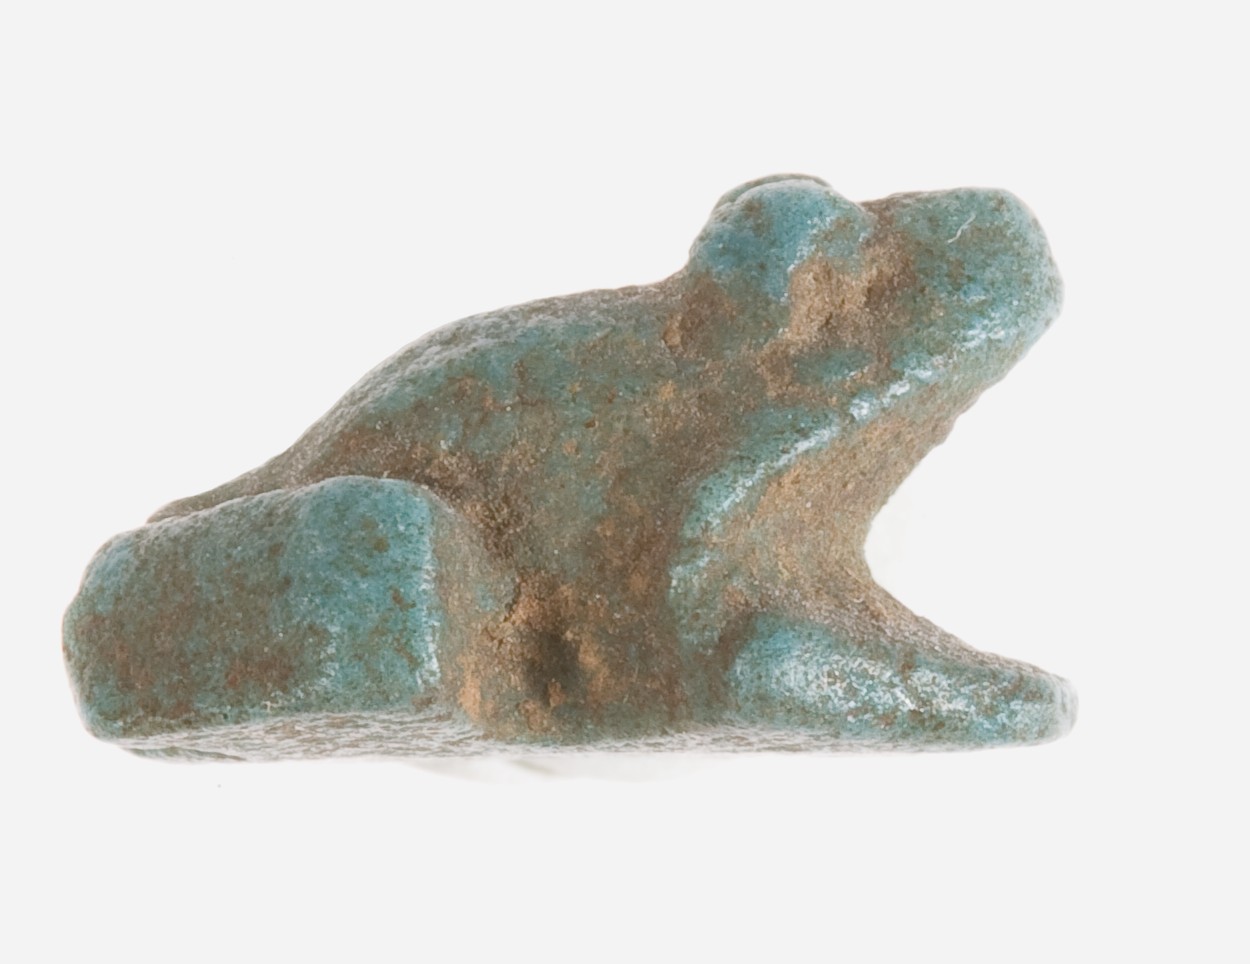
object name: amulet, frog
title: Frog amulet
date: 1550-1070 BCE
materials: faience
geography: egypt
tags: frogs